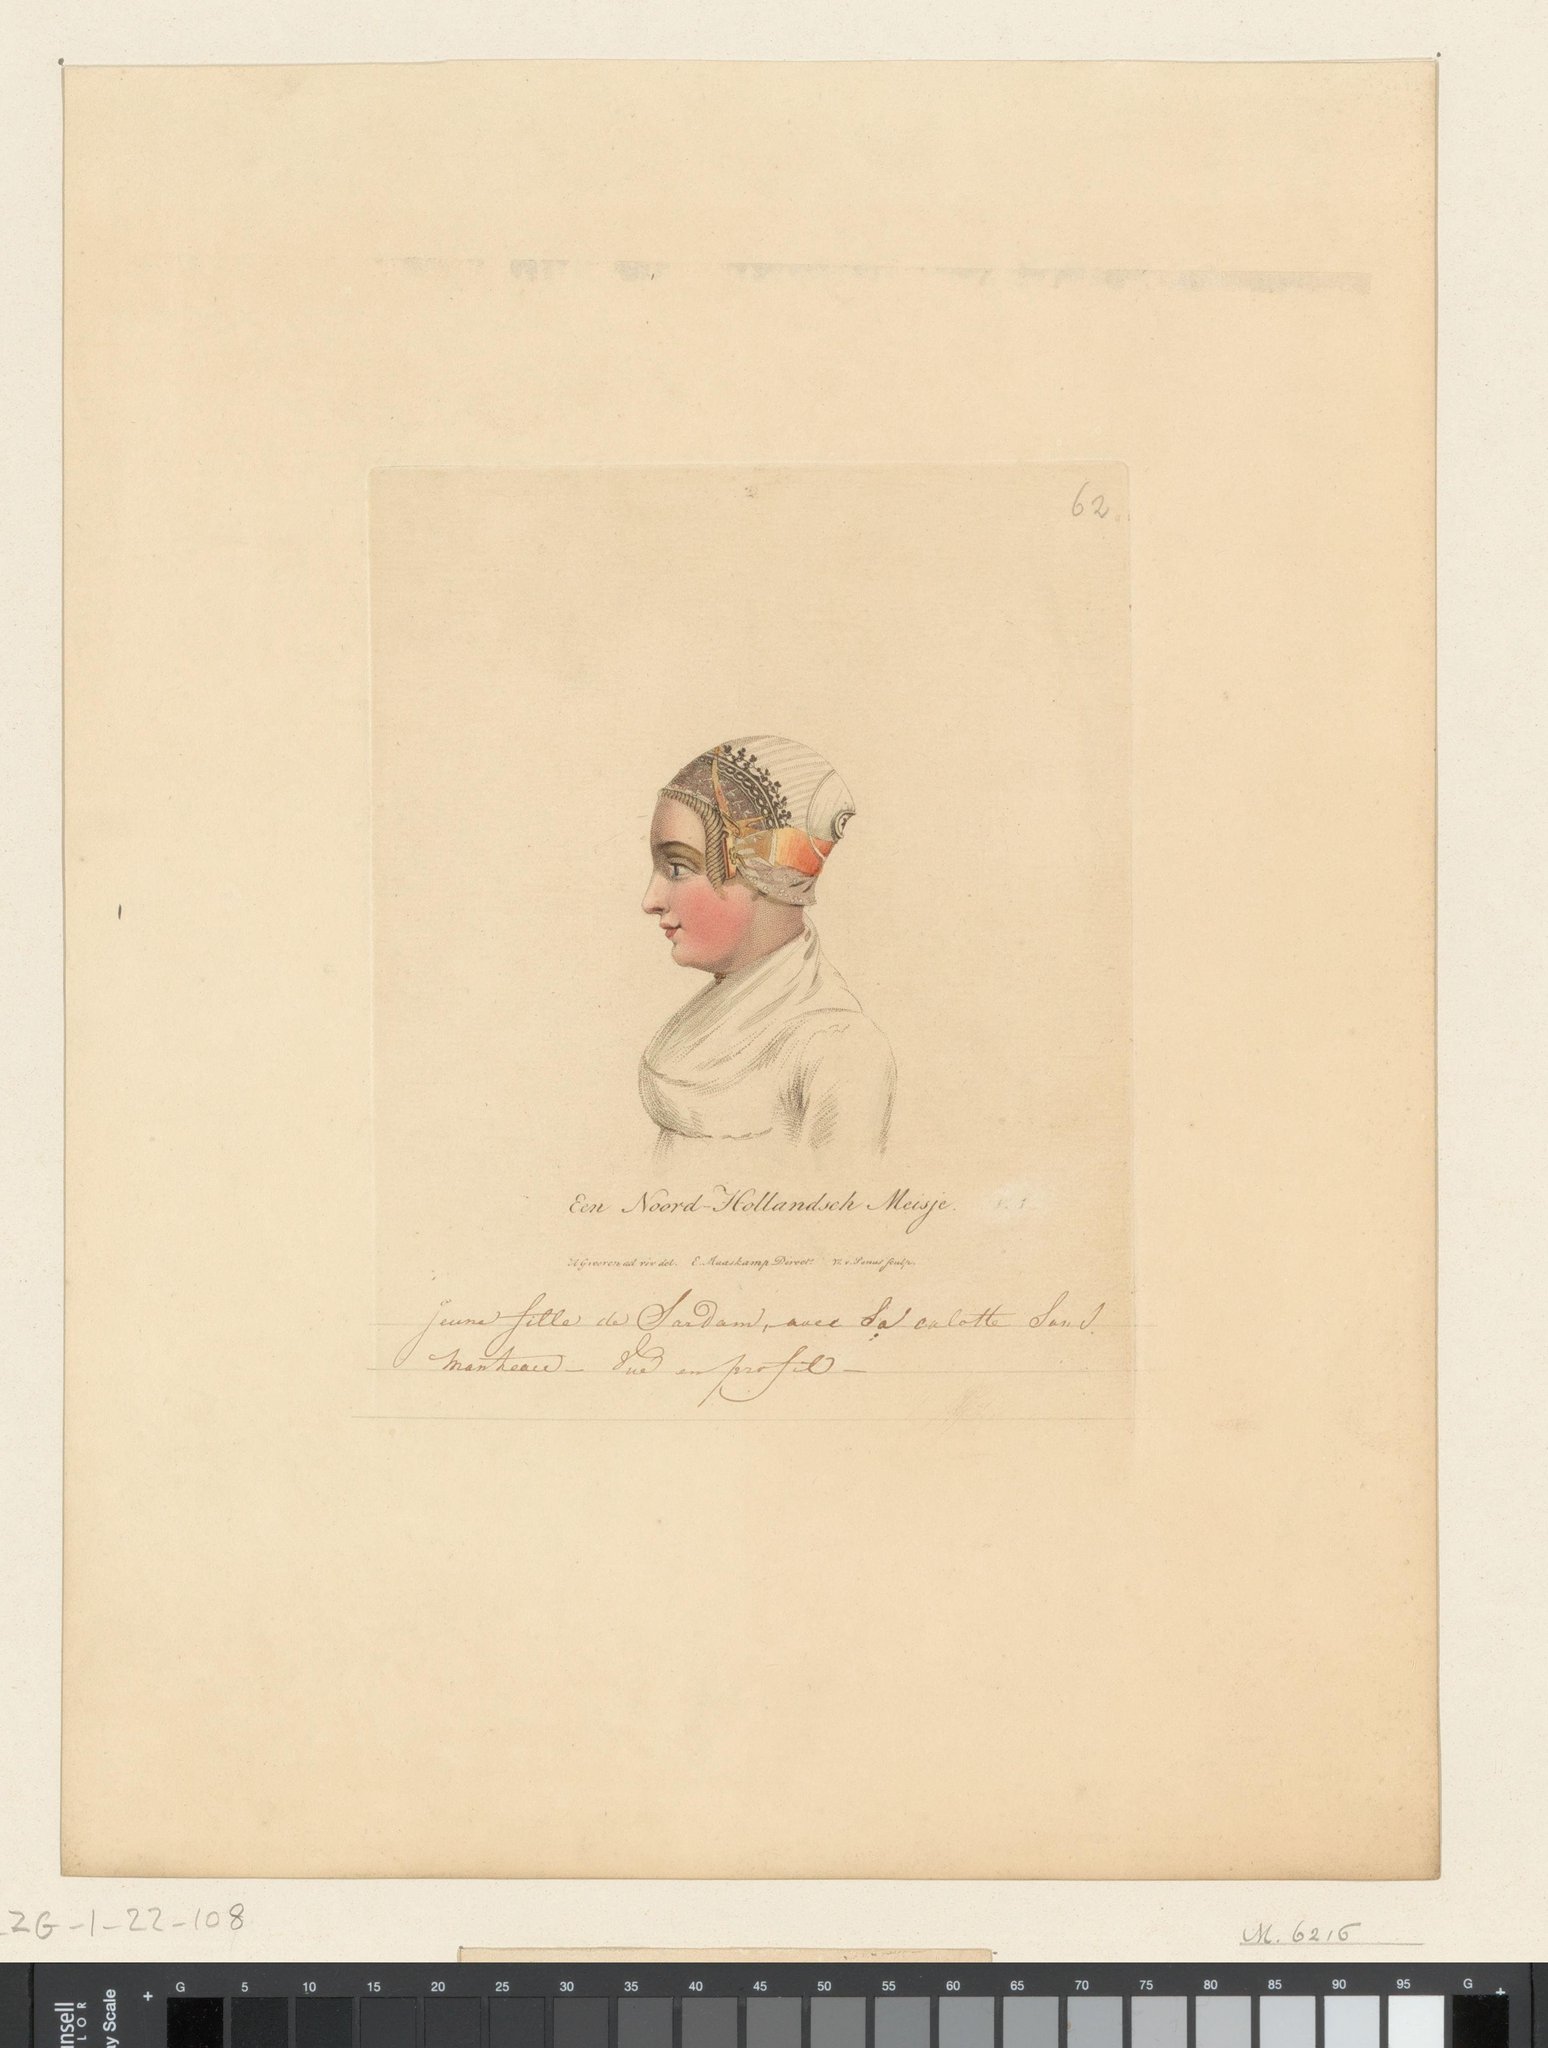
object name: print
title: Een Noord-Hollandsch Meisje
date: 1816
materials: paper, watercolor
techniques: etching, hand coloring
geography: amsterdam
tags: head-gear (+ women's clothes), clothes, costume (+ women's clothes), folk costume, regional costume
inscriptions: collector's mark, collector's mark: Lugt 1641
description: Oorspronkelijk gebruikt als illustratie in: G. Johnson, Karakterschetsen : zeden en gewoonten van Nederlandsche mannen en vrouwen, in het jaar 1816 bijeenverzameld op eene reize door het Koningrijk der Nederlanden. E. Maaskamp: Amsterdam, [1816]. Daarna heruitgegeven in: Maaskamp, Evert. Tableau des principales vues des palais et édifices : représentations et des coutumes et usages, dans les provinces septentrionales du Royaume des Pays-Bas. Amsterdam, 1824.